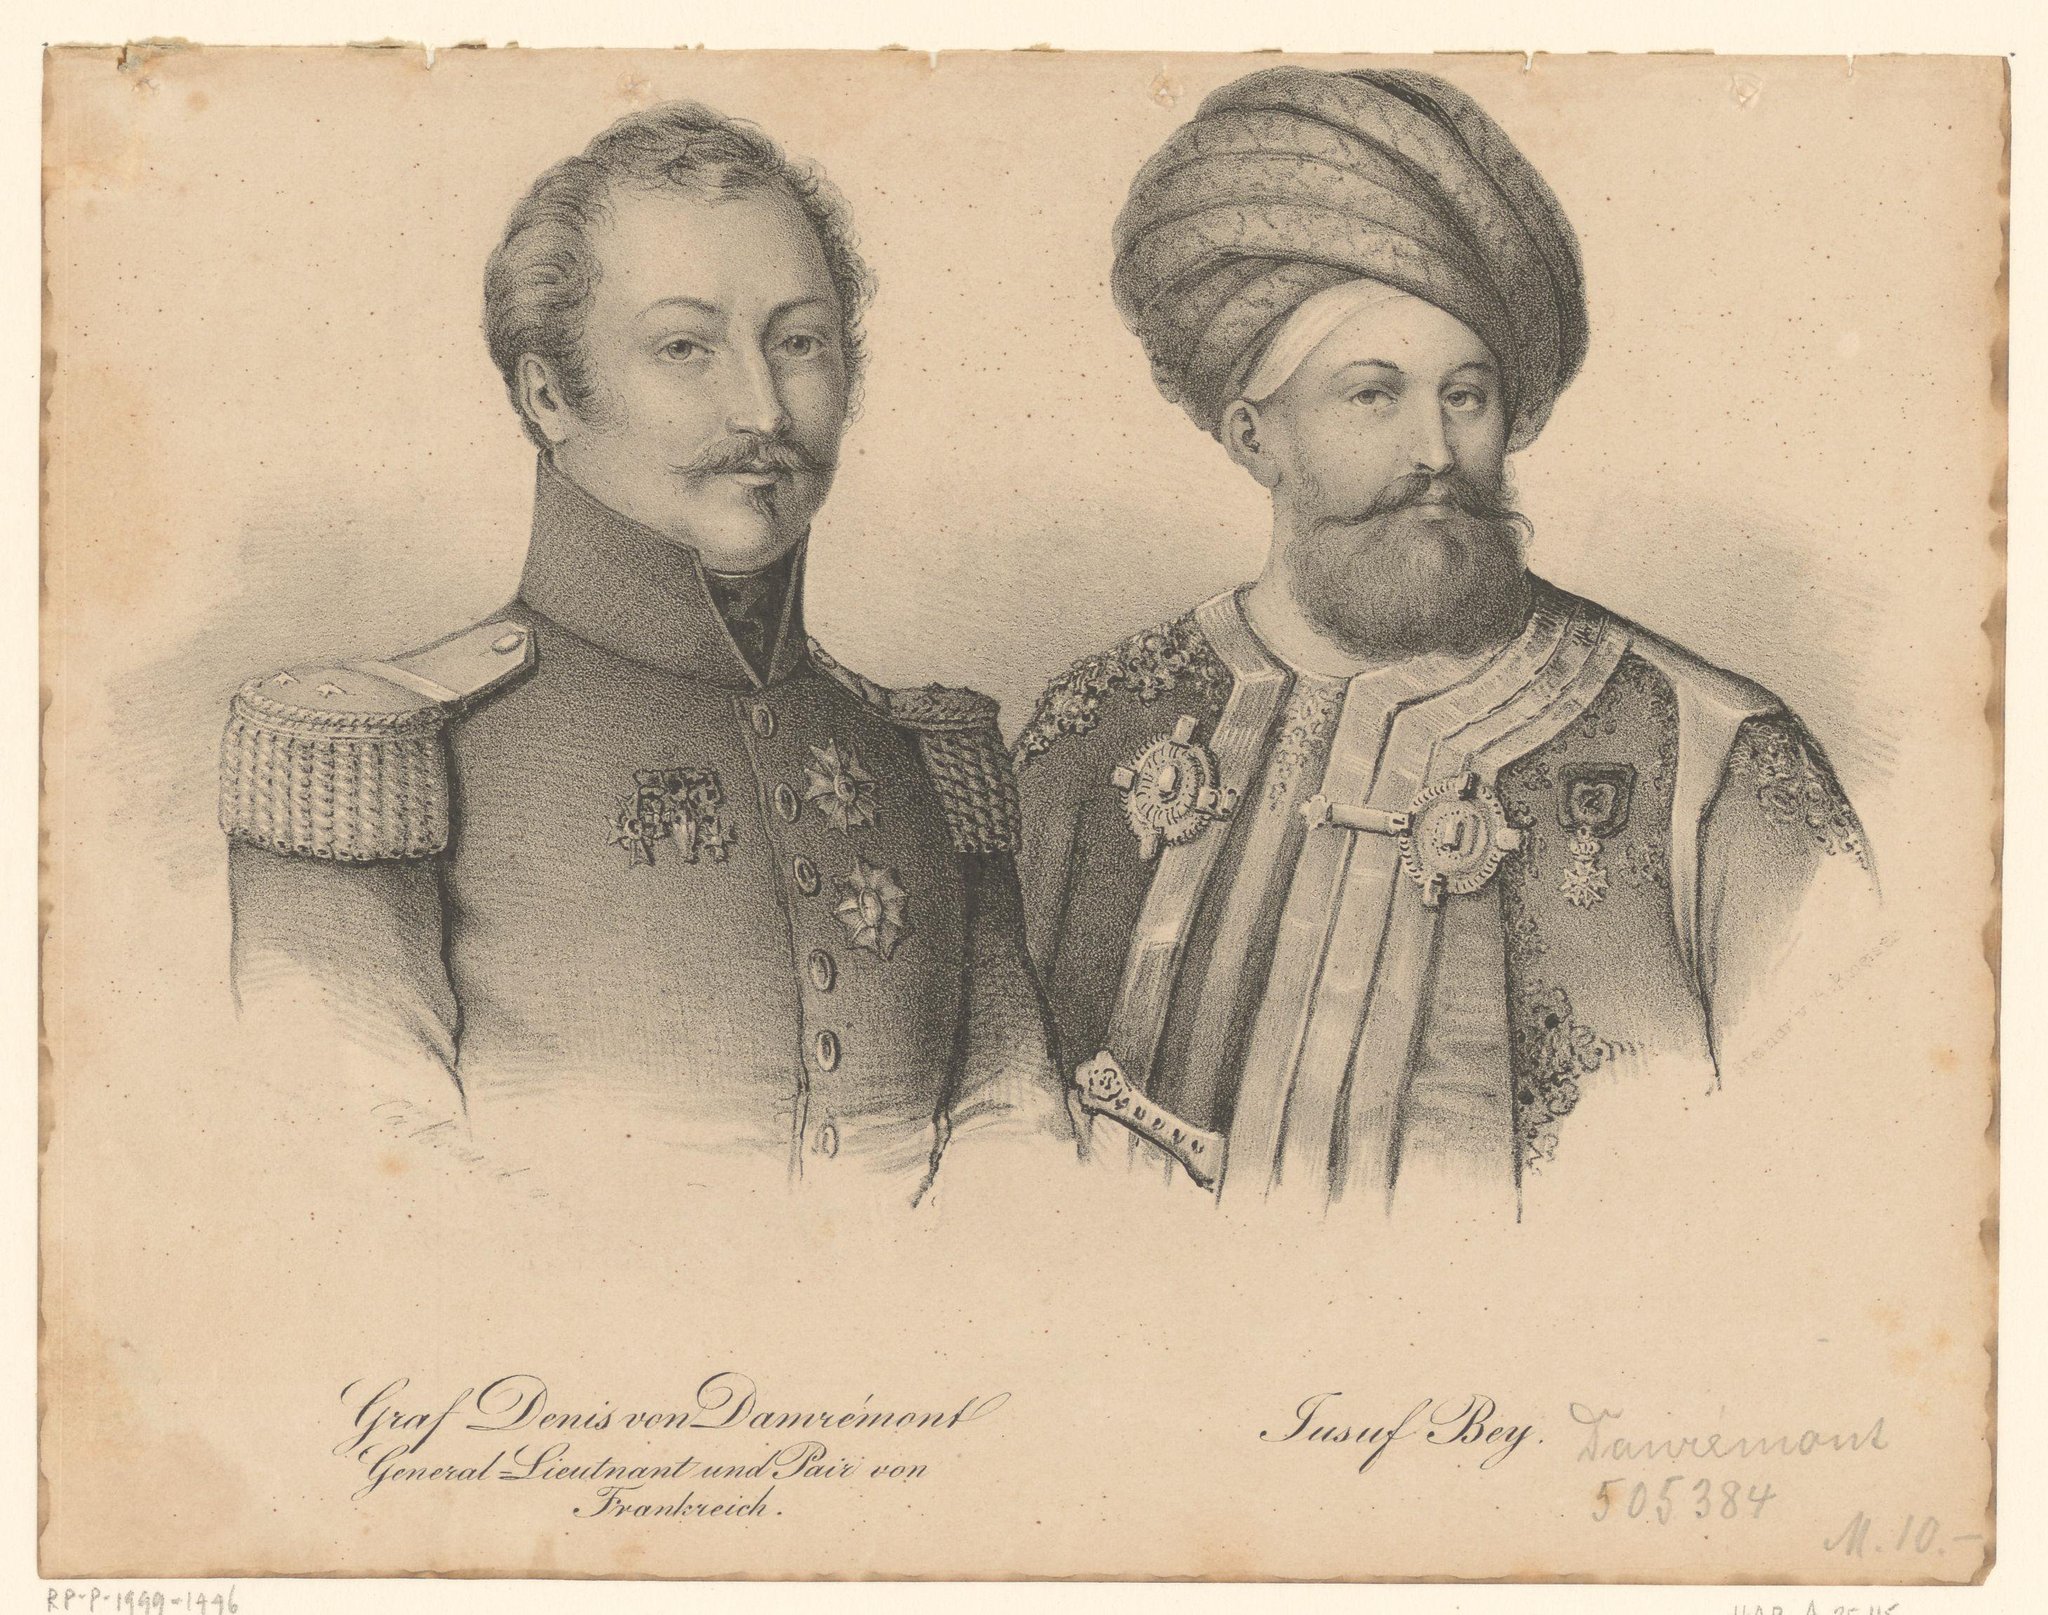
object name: print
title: Graf Denis von Damrémont General Lieutnant und Pair von Frankreich, Jusuf Bey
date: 1825-1850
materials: paper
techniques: lithograph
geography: leipzig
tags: adult man, historical persons, head-gear: turban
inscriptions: collector's mark: Lugt 2760, collector's mark: Lugt 2228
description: Dubbelportret. Buste van Jusuf Bey (rechts) en van Graaf Denis de Damrémont, Frans generaal-luitenant.